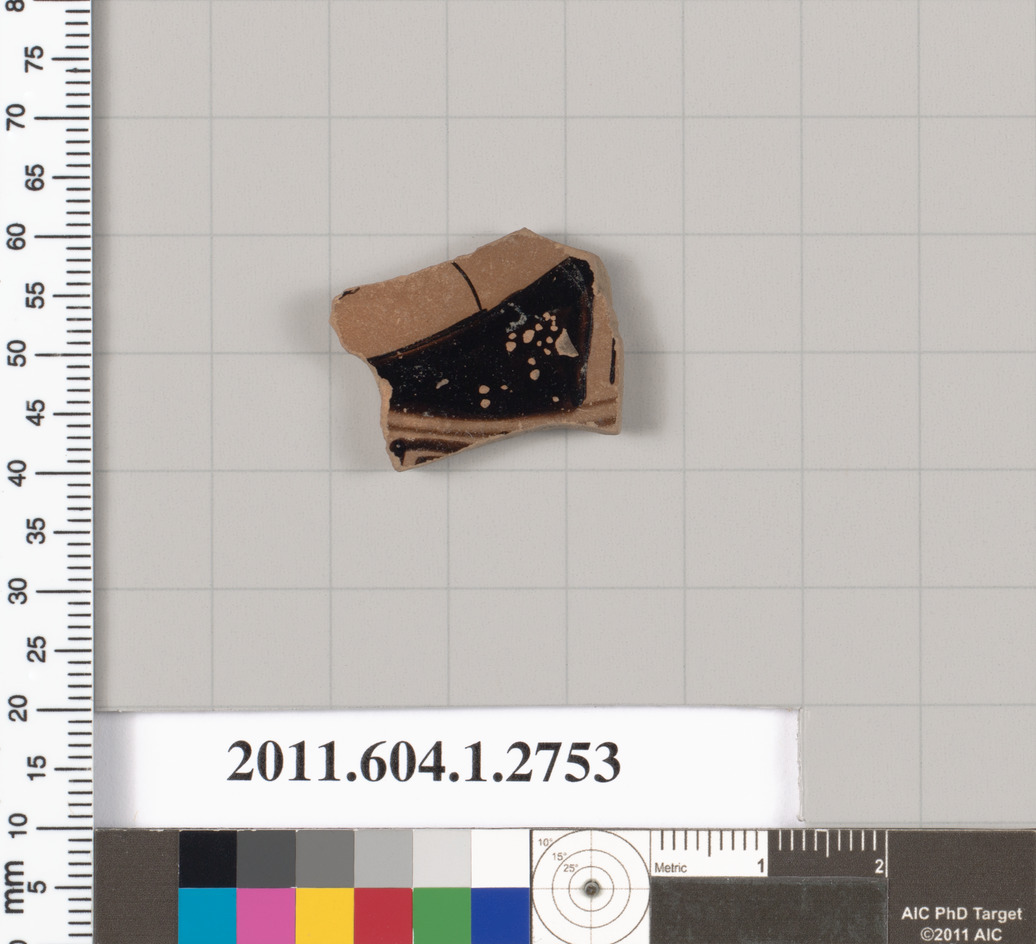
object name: kylix fragment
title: Terracotta fragment of a kylix (drinking cup)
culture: greek, attic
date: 500-480 BCE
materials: terracotta